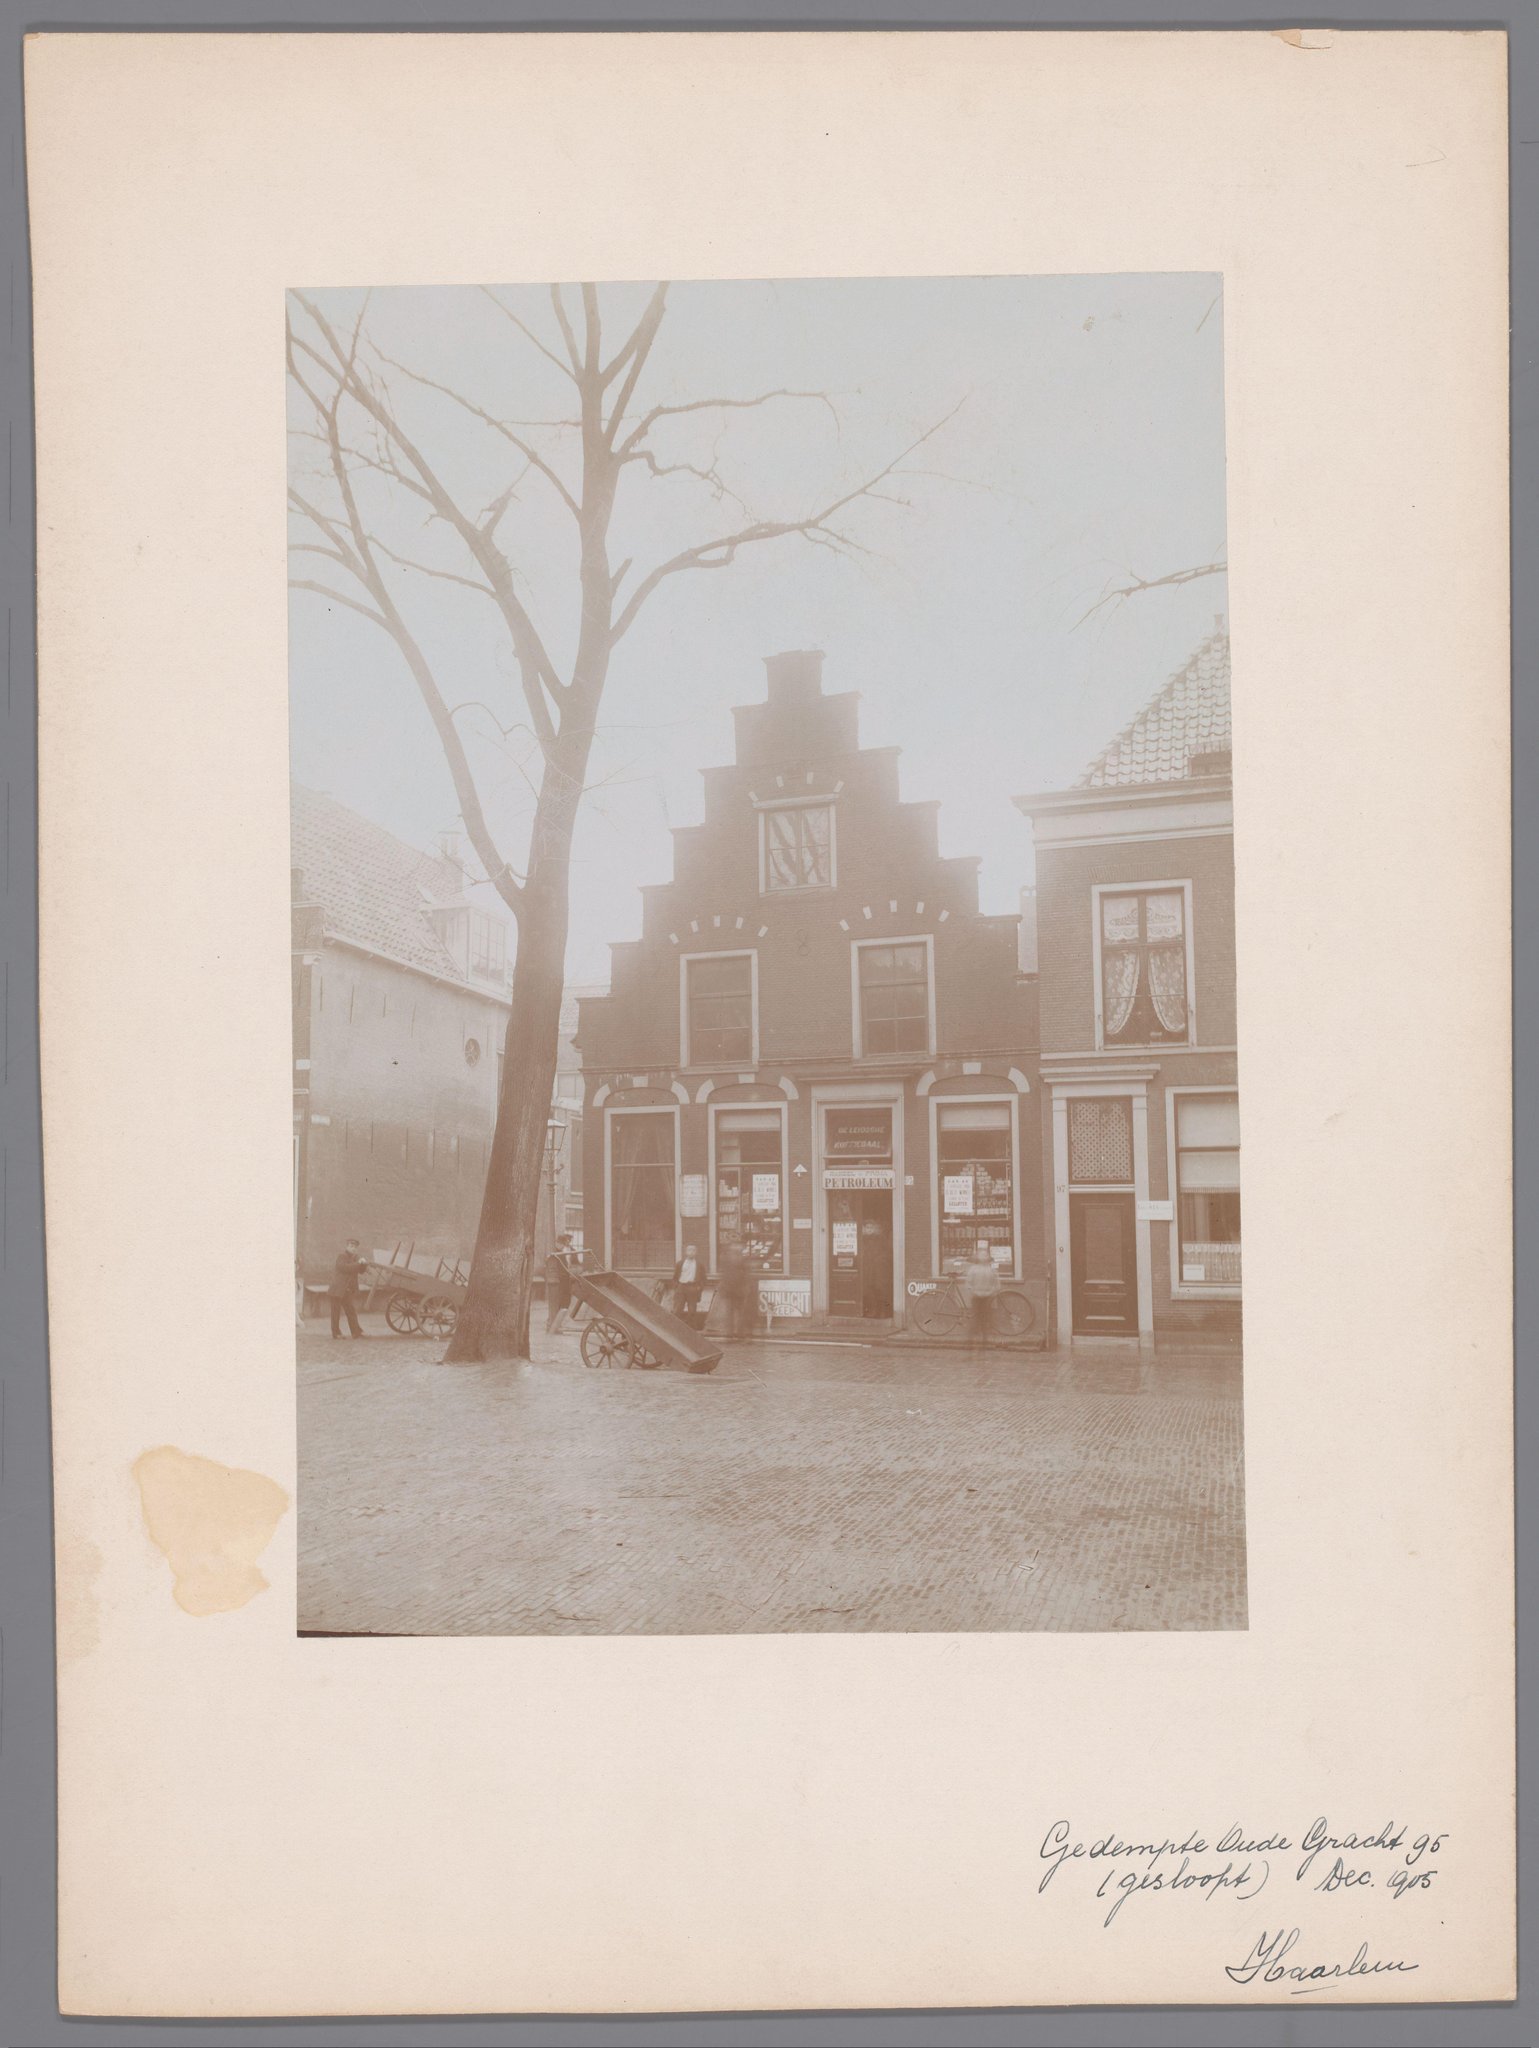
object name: photograph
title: Pand op de Gedempte Oude Gracht 95 te Haarlem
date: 1905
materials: cardboard, photographic support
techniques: collodion silver print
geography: gedempte oude gracht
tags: shop, store, façade (of house or building), street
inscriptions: annotation: ‘Gedempte Oude Gracht - 95 - gesloopt/ Haarlem (N.H.)/ Dec 1905’, annotation: ‘Gedempte Oude Gracht 95/ (gesloopt) Dec. 1905/ Haarlem’